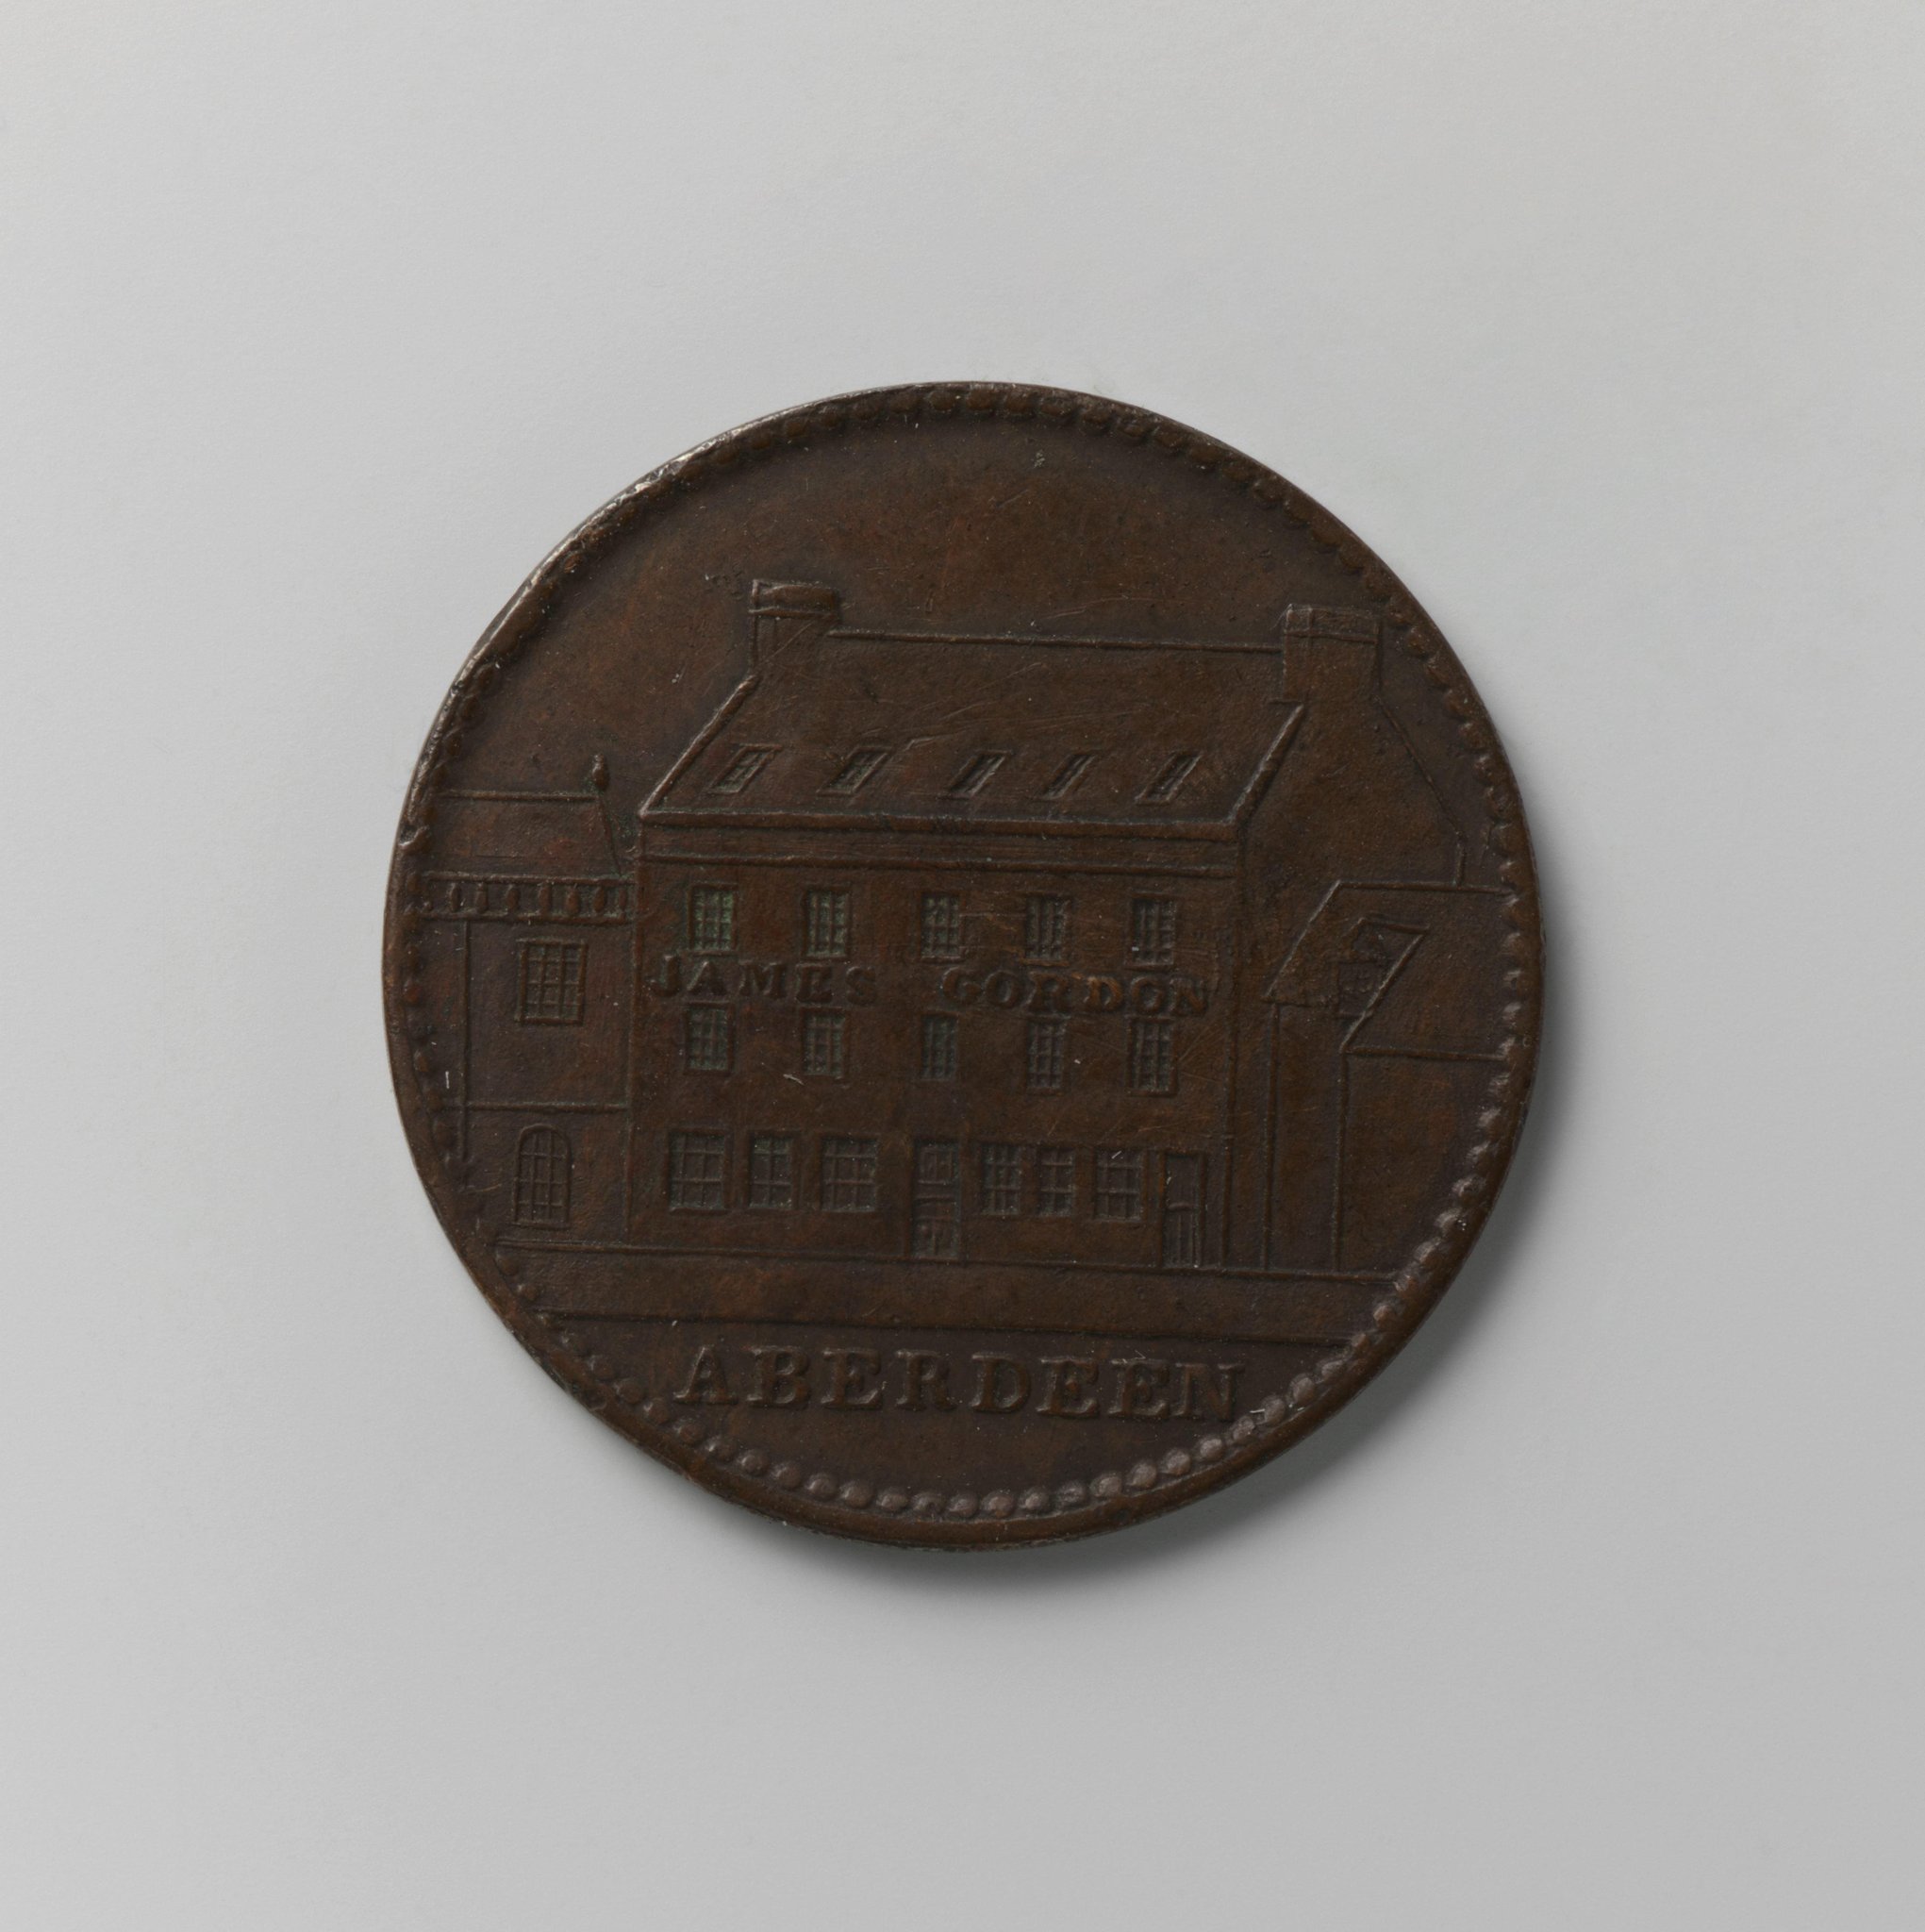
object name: farthing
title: betaalpenning (token) voor een farthing uit Aberdeen, Schotland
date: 1790-1817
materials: copper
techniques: striking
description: Koperen particuliere munt. Voorzijde: kantoorcomplex. Keerzijde: zes- regelig opschrift. Gladde rand.